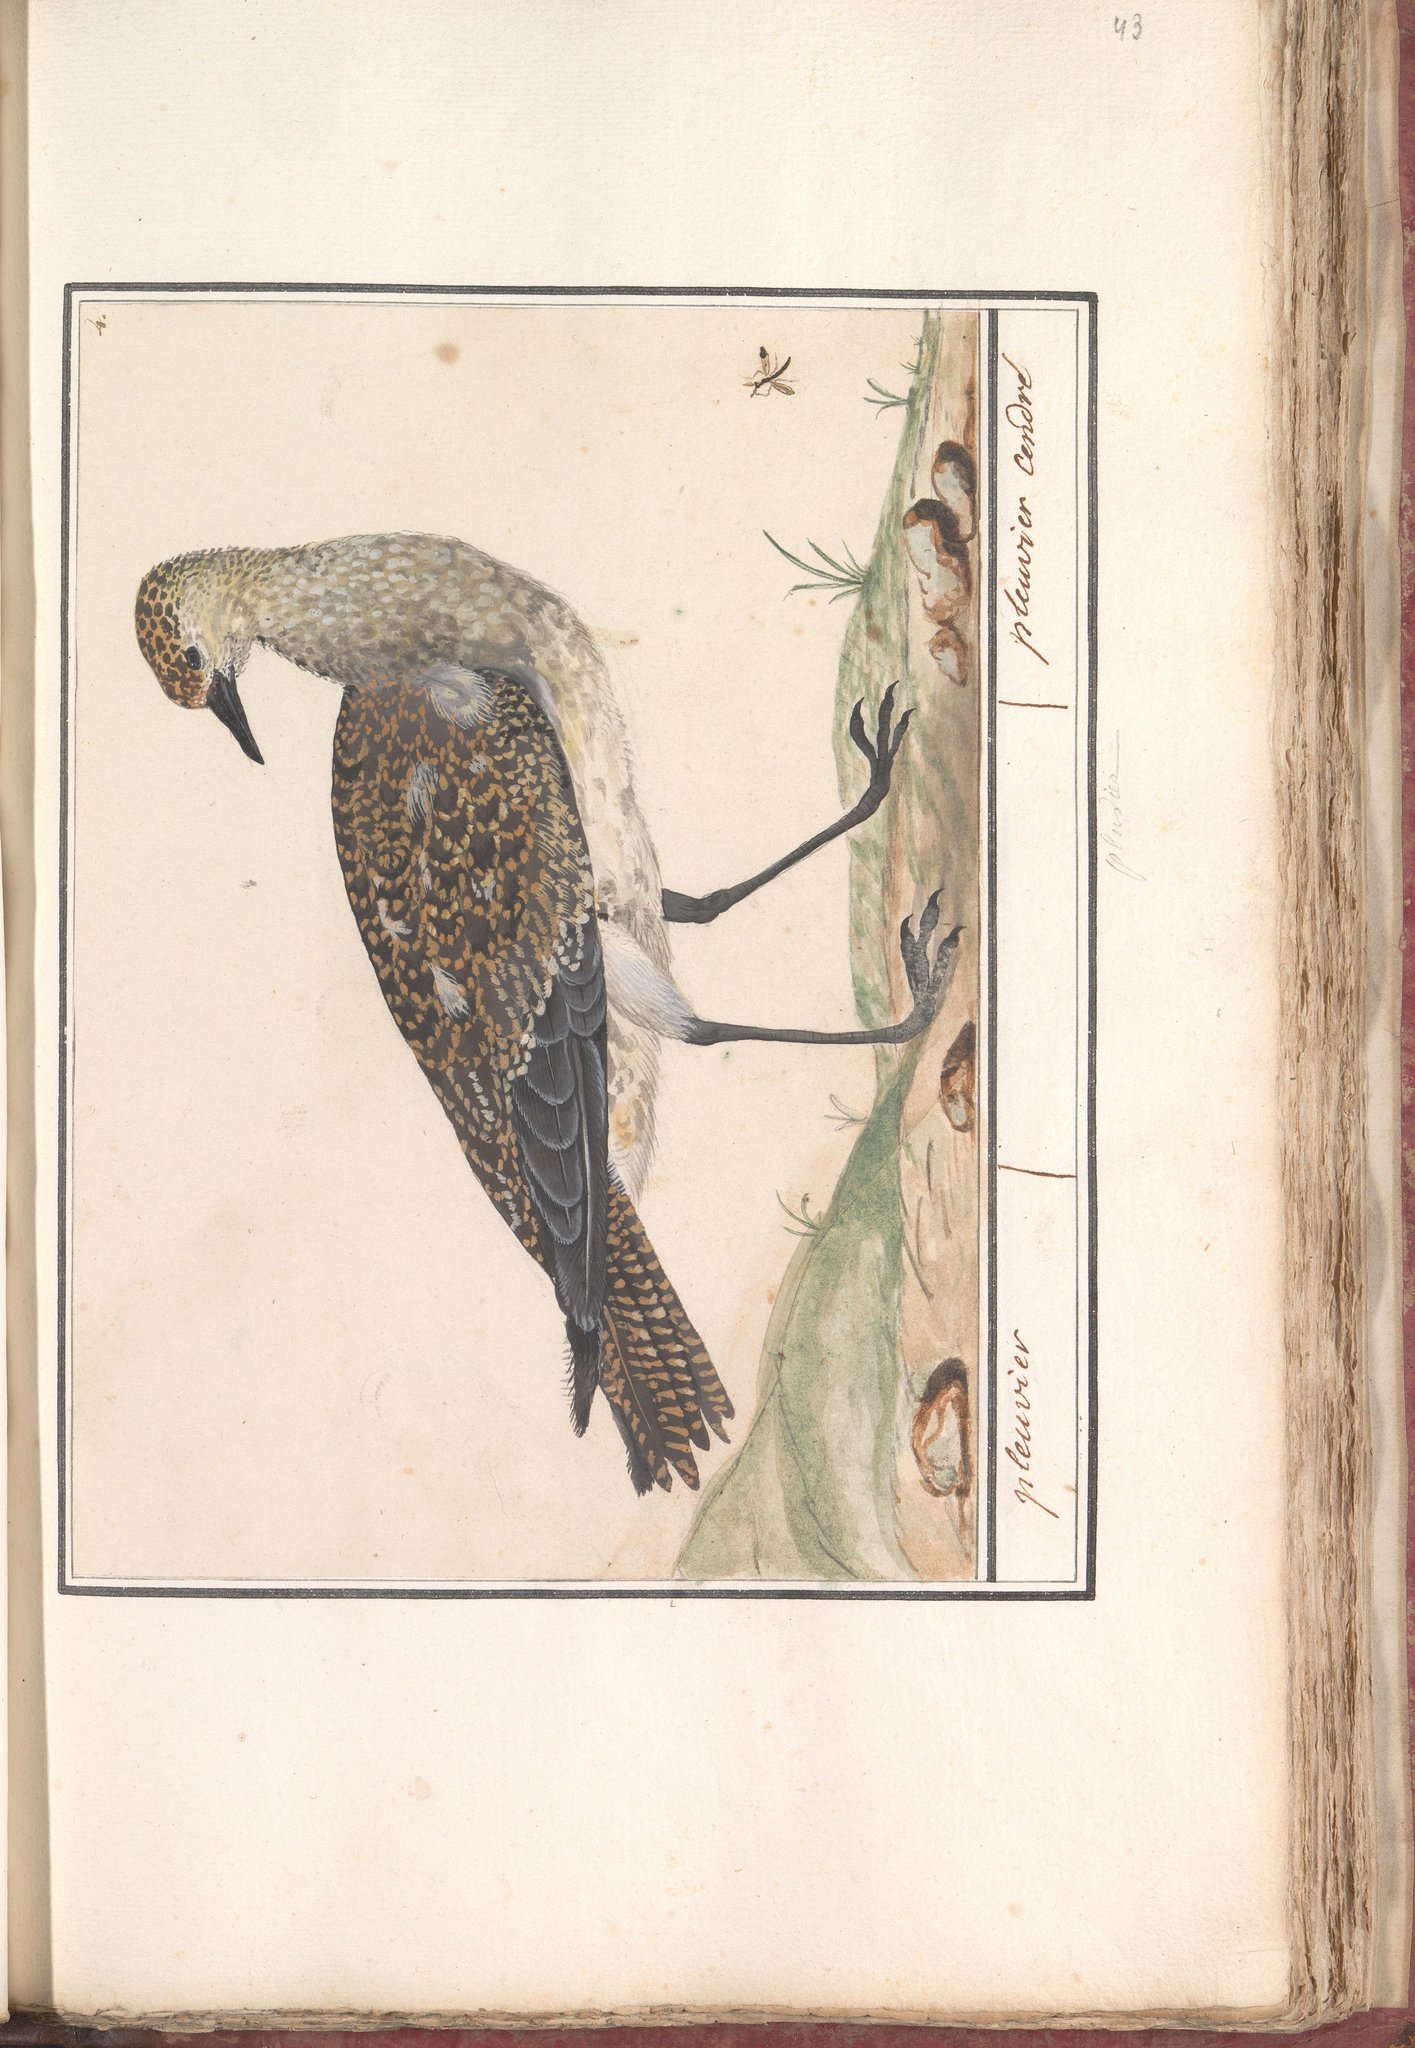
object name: drawing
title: pleuvier / pleuvier cendré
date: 1596-1610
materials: chalk, paint, paper, pencil, watercolor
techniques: brush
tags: shore-birds and wading-birds: golden plover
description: Goudplevier. Genummerd rechtsboven: 4. Onderdeel van het derde album met tekeningen van vogels. Vijfde van twaalf albums met tekeningen van dieren, vogels en planten bekend rond 1600, gemaakt in opdracht van keizer Rudolf II. Met toelichting in Nederlands, Latijn en Frans.